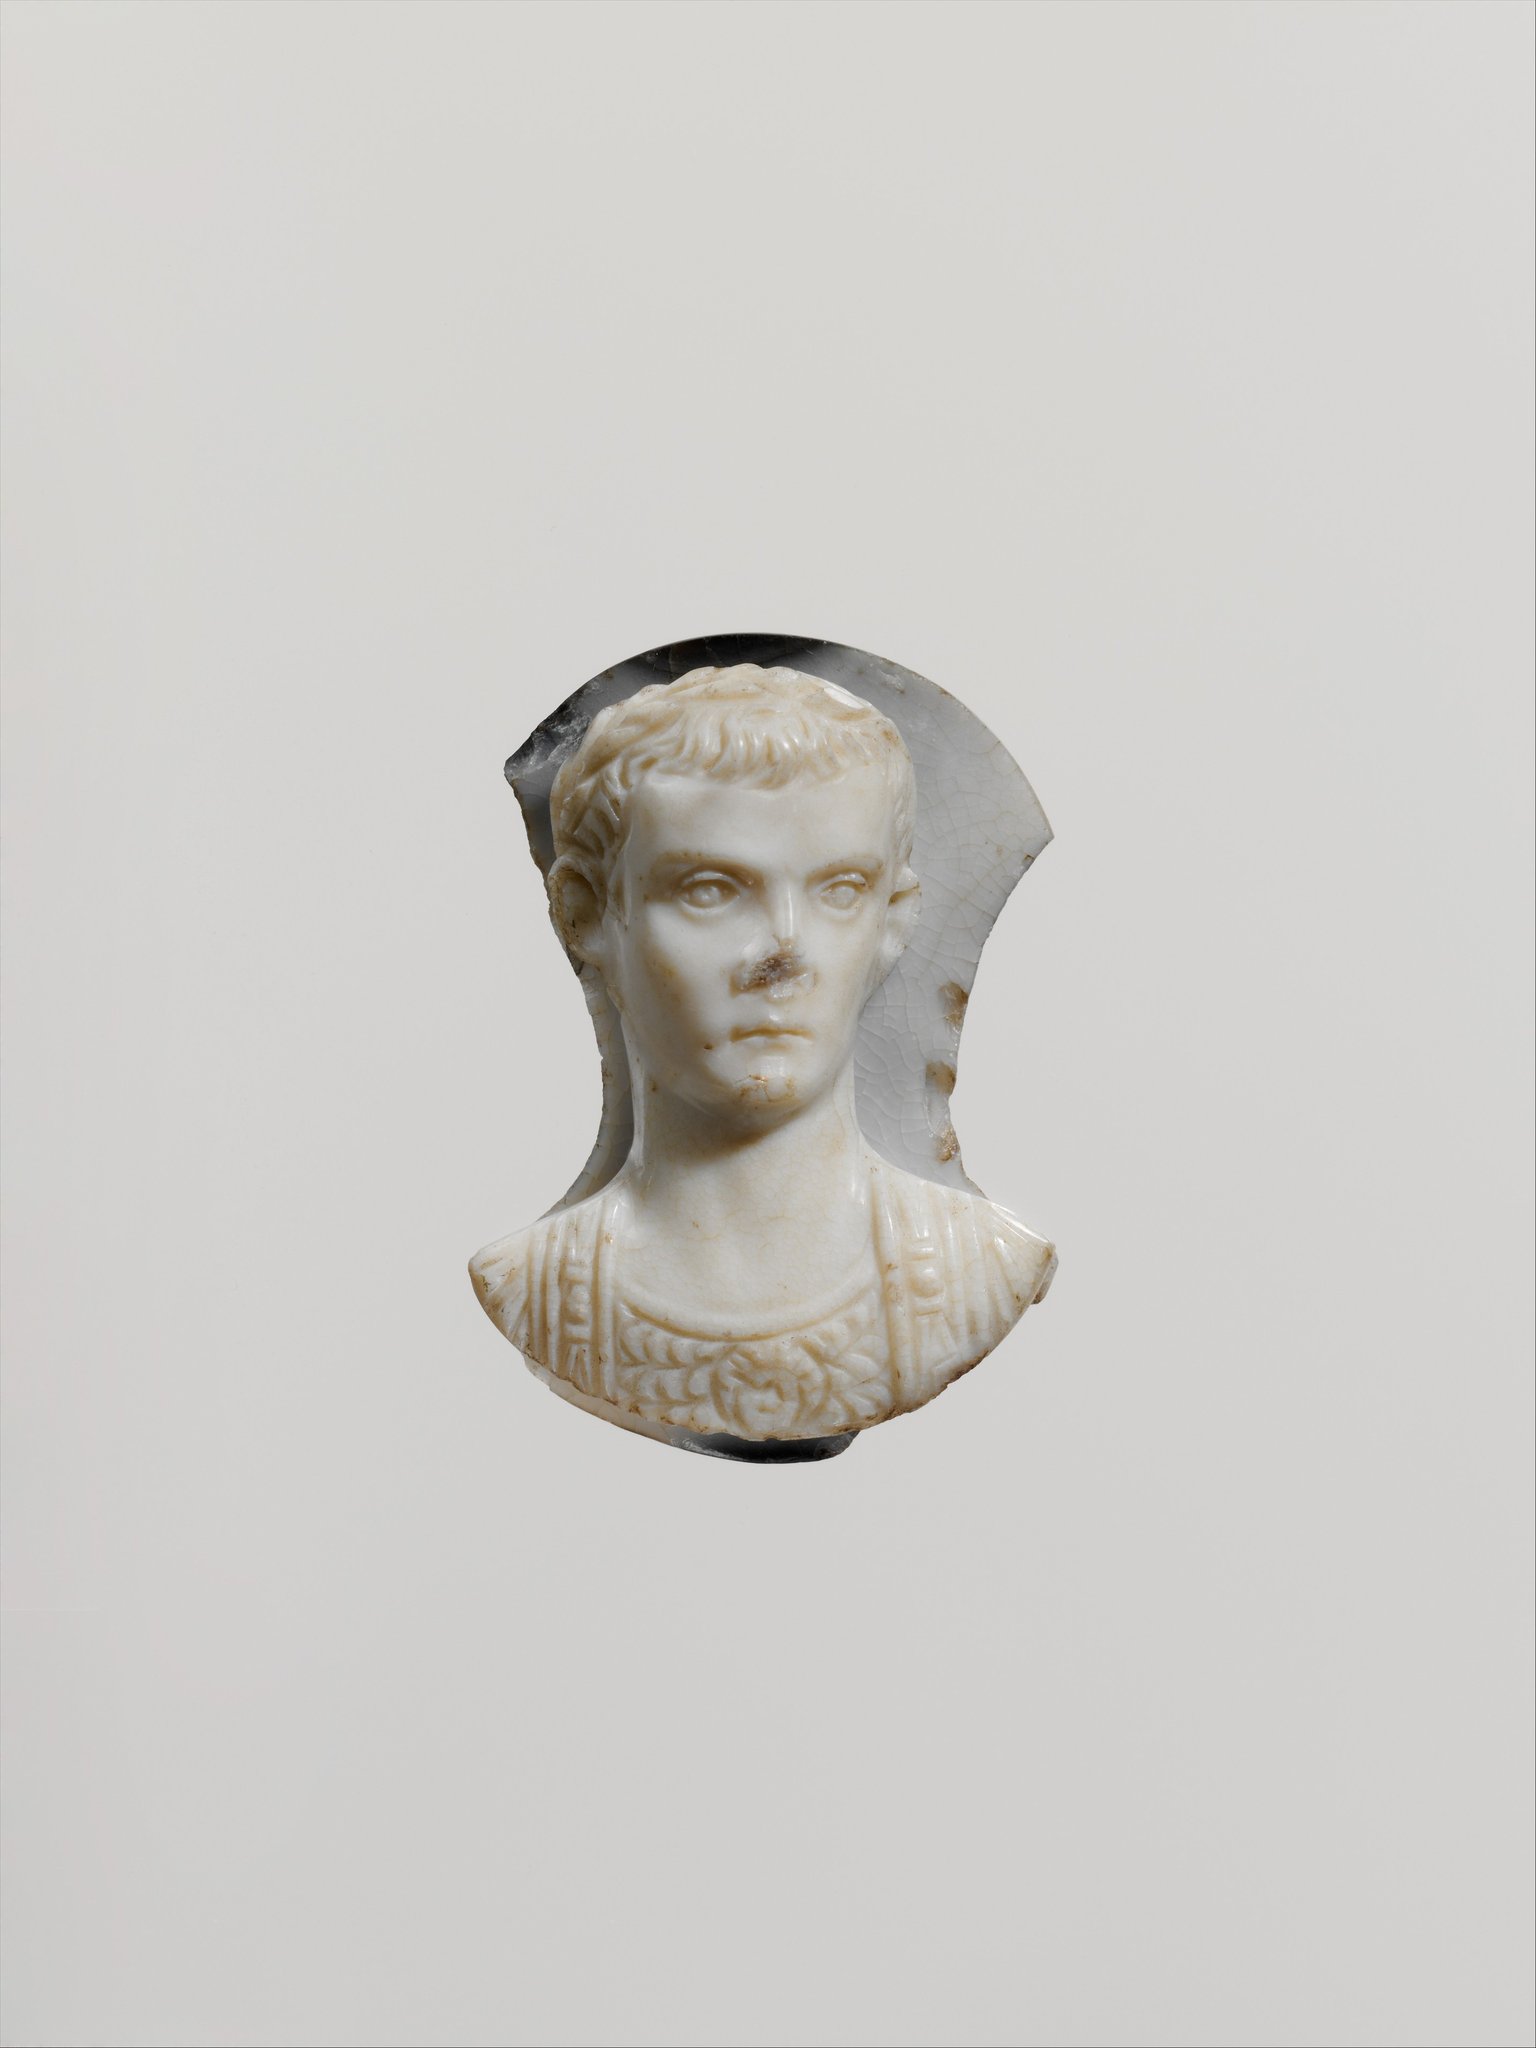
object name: cameo, portrait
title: Onyx cameo of the emperor Gaius (Caligula)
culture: roman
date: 37-43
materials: onyx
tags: emperors,men